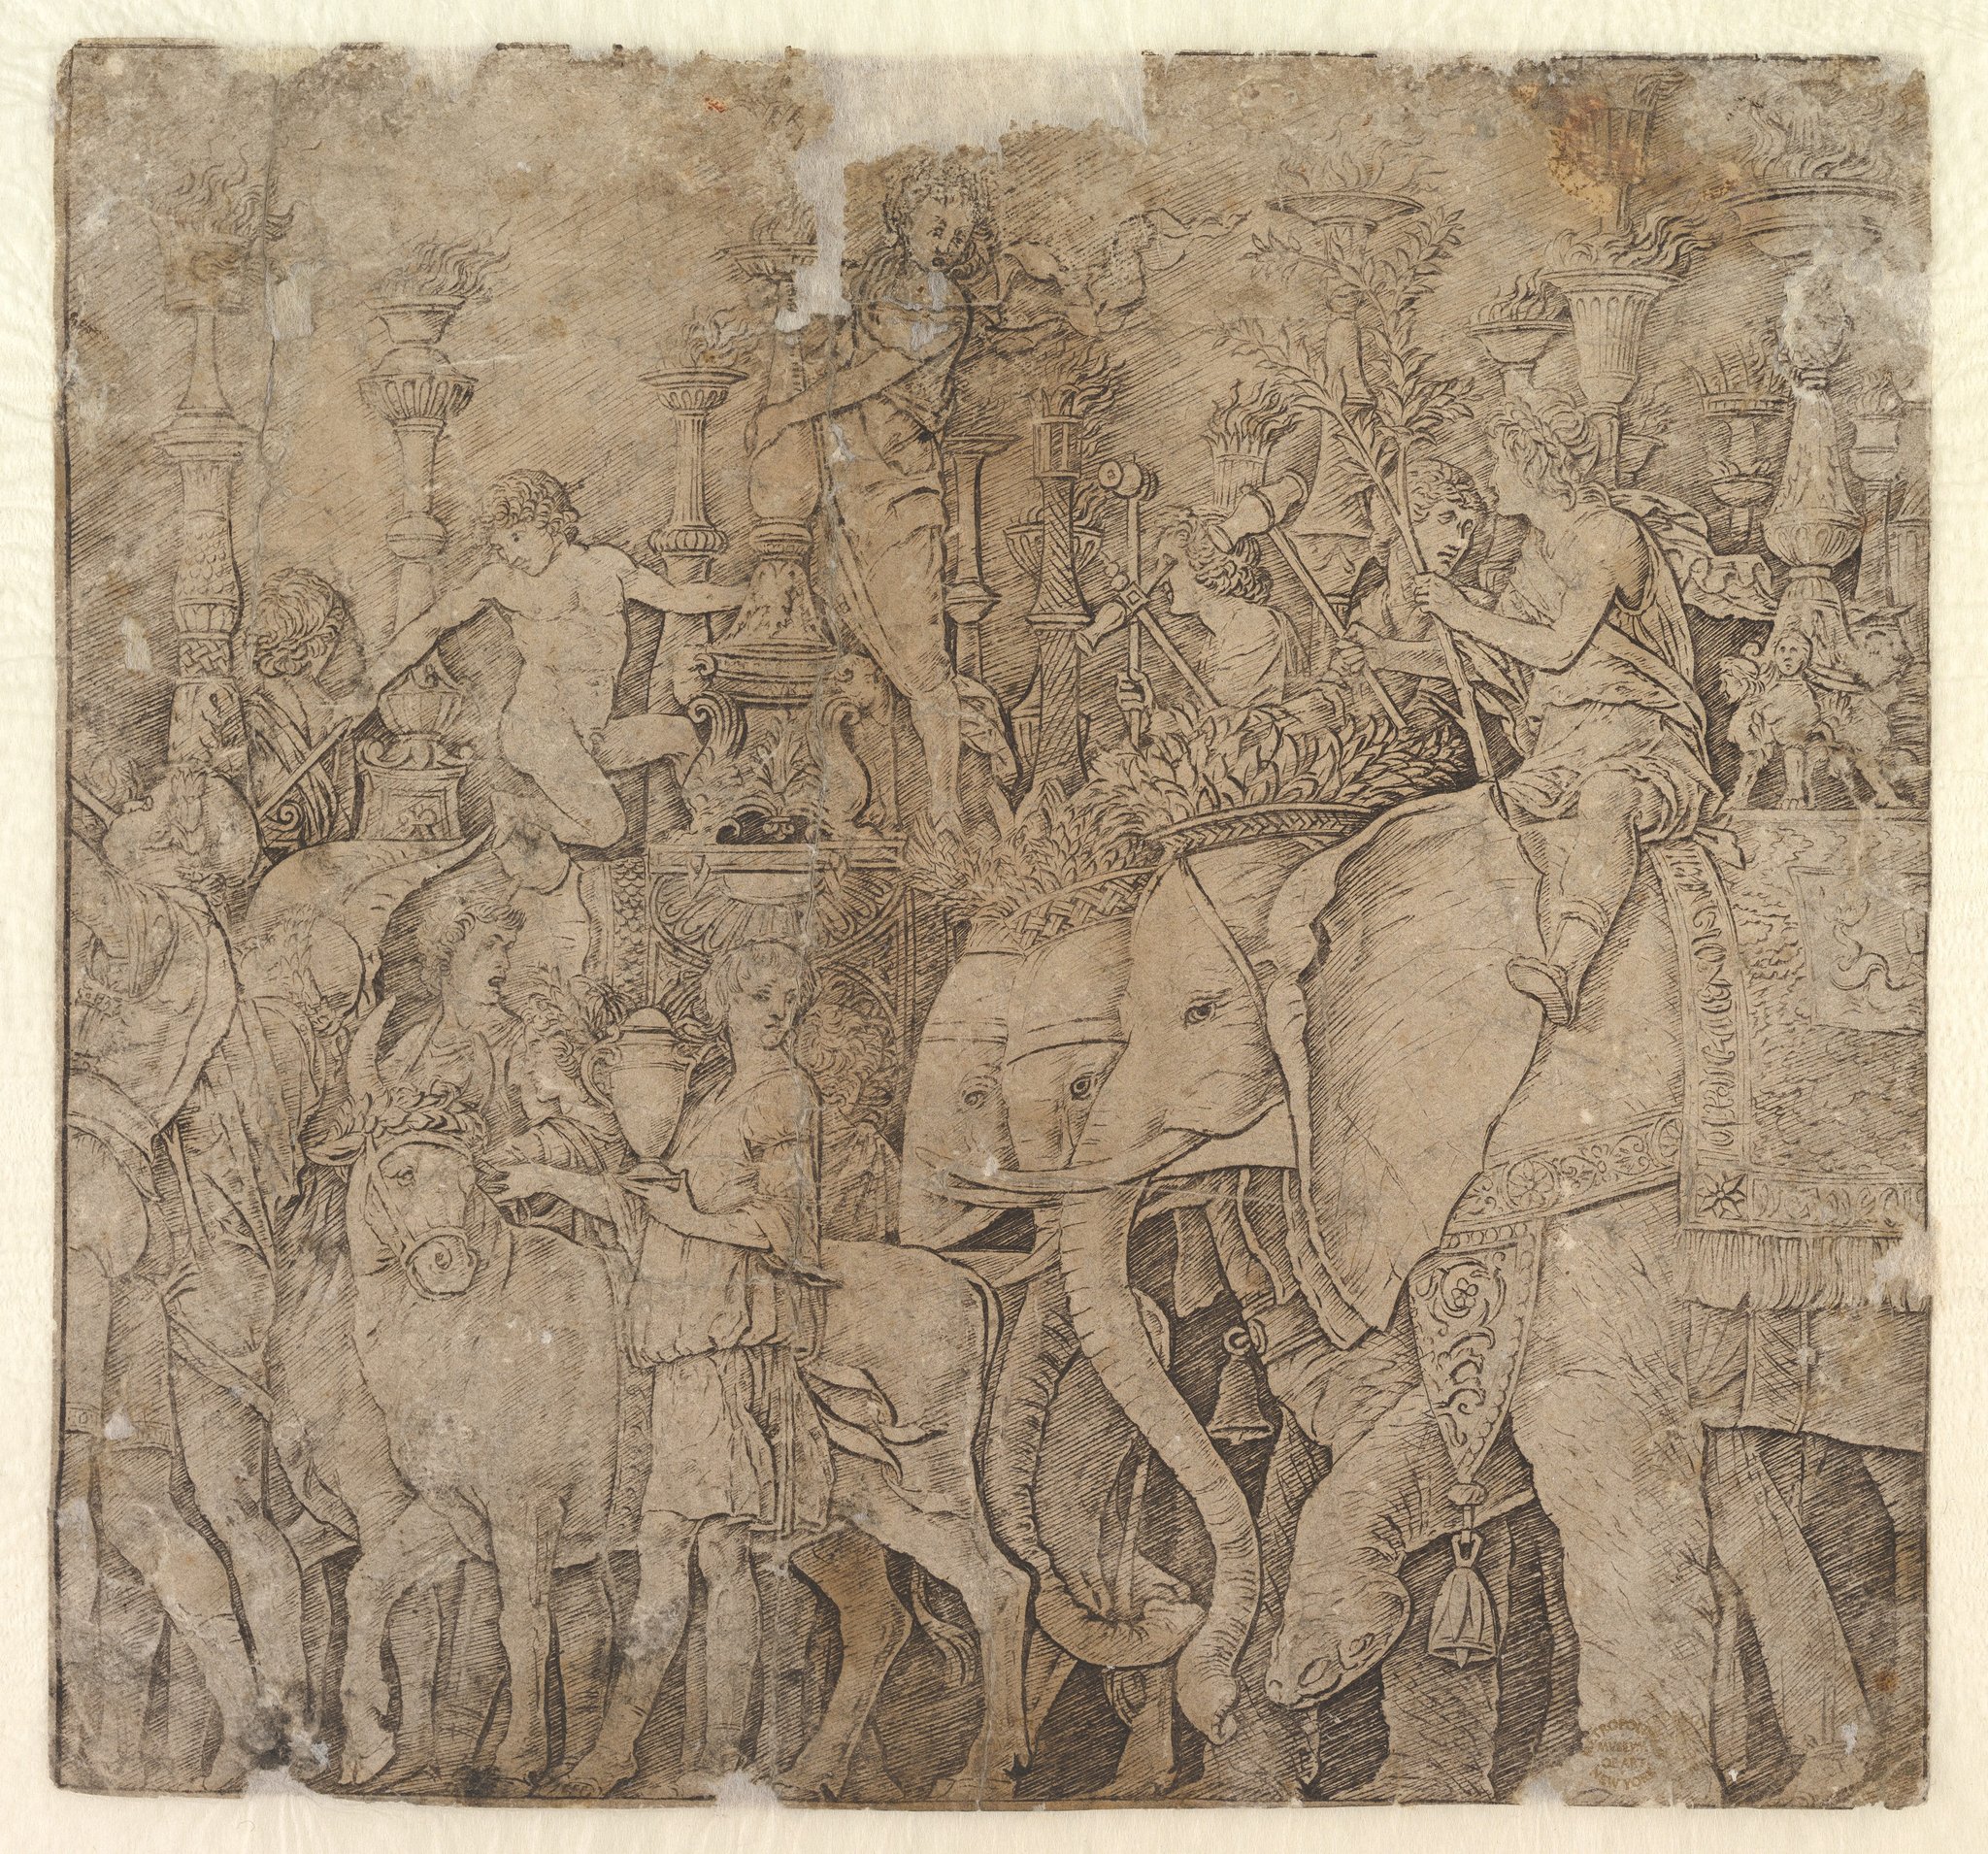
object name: print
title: Triumph of Julius Caesar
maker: andrea mantegna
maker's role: artist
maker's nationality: italian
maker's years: 1431-1506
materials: ink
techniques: engraving, pen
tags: julius caesar,male nudes,cows,elephants